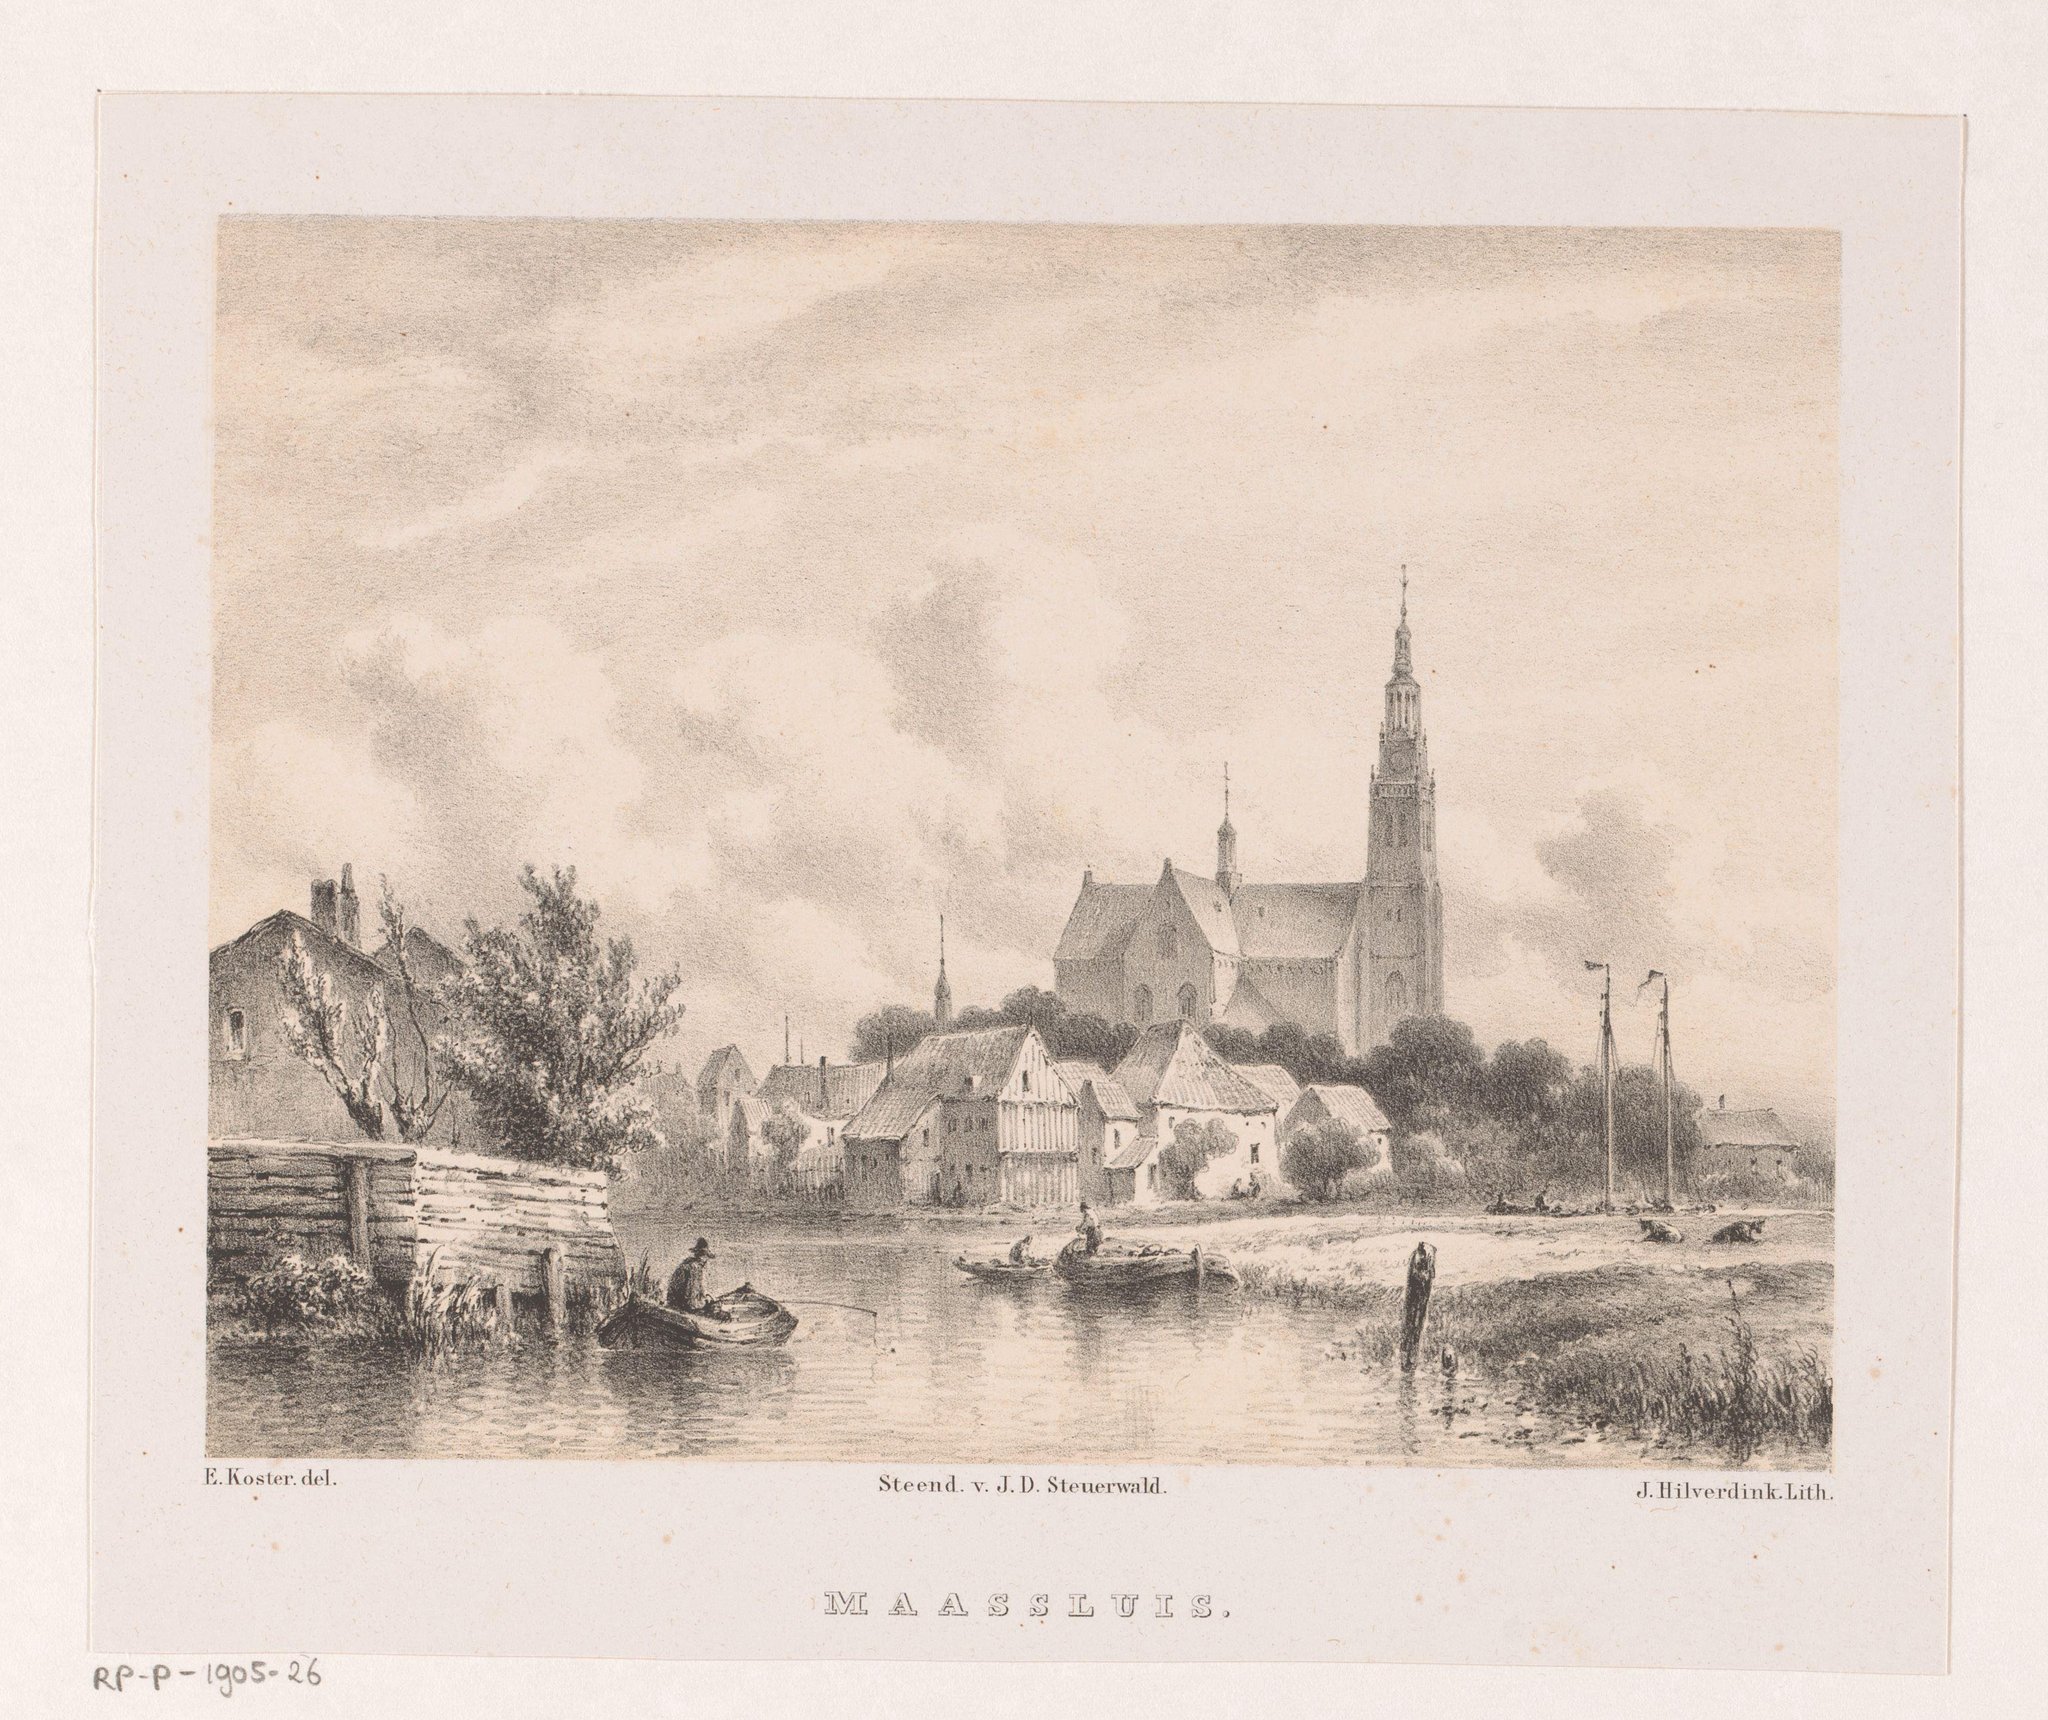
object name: print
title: Gezicht op Maassluis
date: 1858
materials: paper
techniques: tone lithography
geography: amsterdam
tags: ships (in general), church (exterior), city-view, and landscape with man-made constructions (+ city(-scape) with figures, staffage)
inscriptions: collector's mark: Lugt 2228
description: Deze prent komt uit: Koster, E. 'E. Koster's schetsboek: Nederlandsche Stads- en Havengezichten, uitgegeven onder medewerking van de maatschappij Arti et Amicitiae, Amsterdam, F. Buffa en Zn., e.a.' Amsterdam 1858.